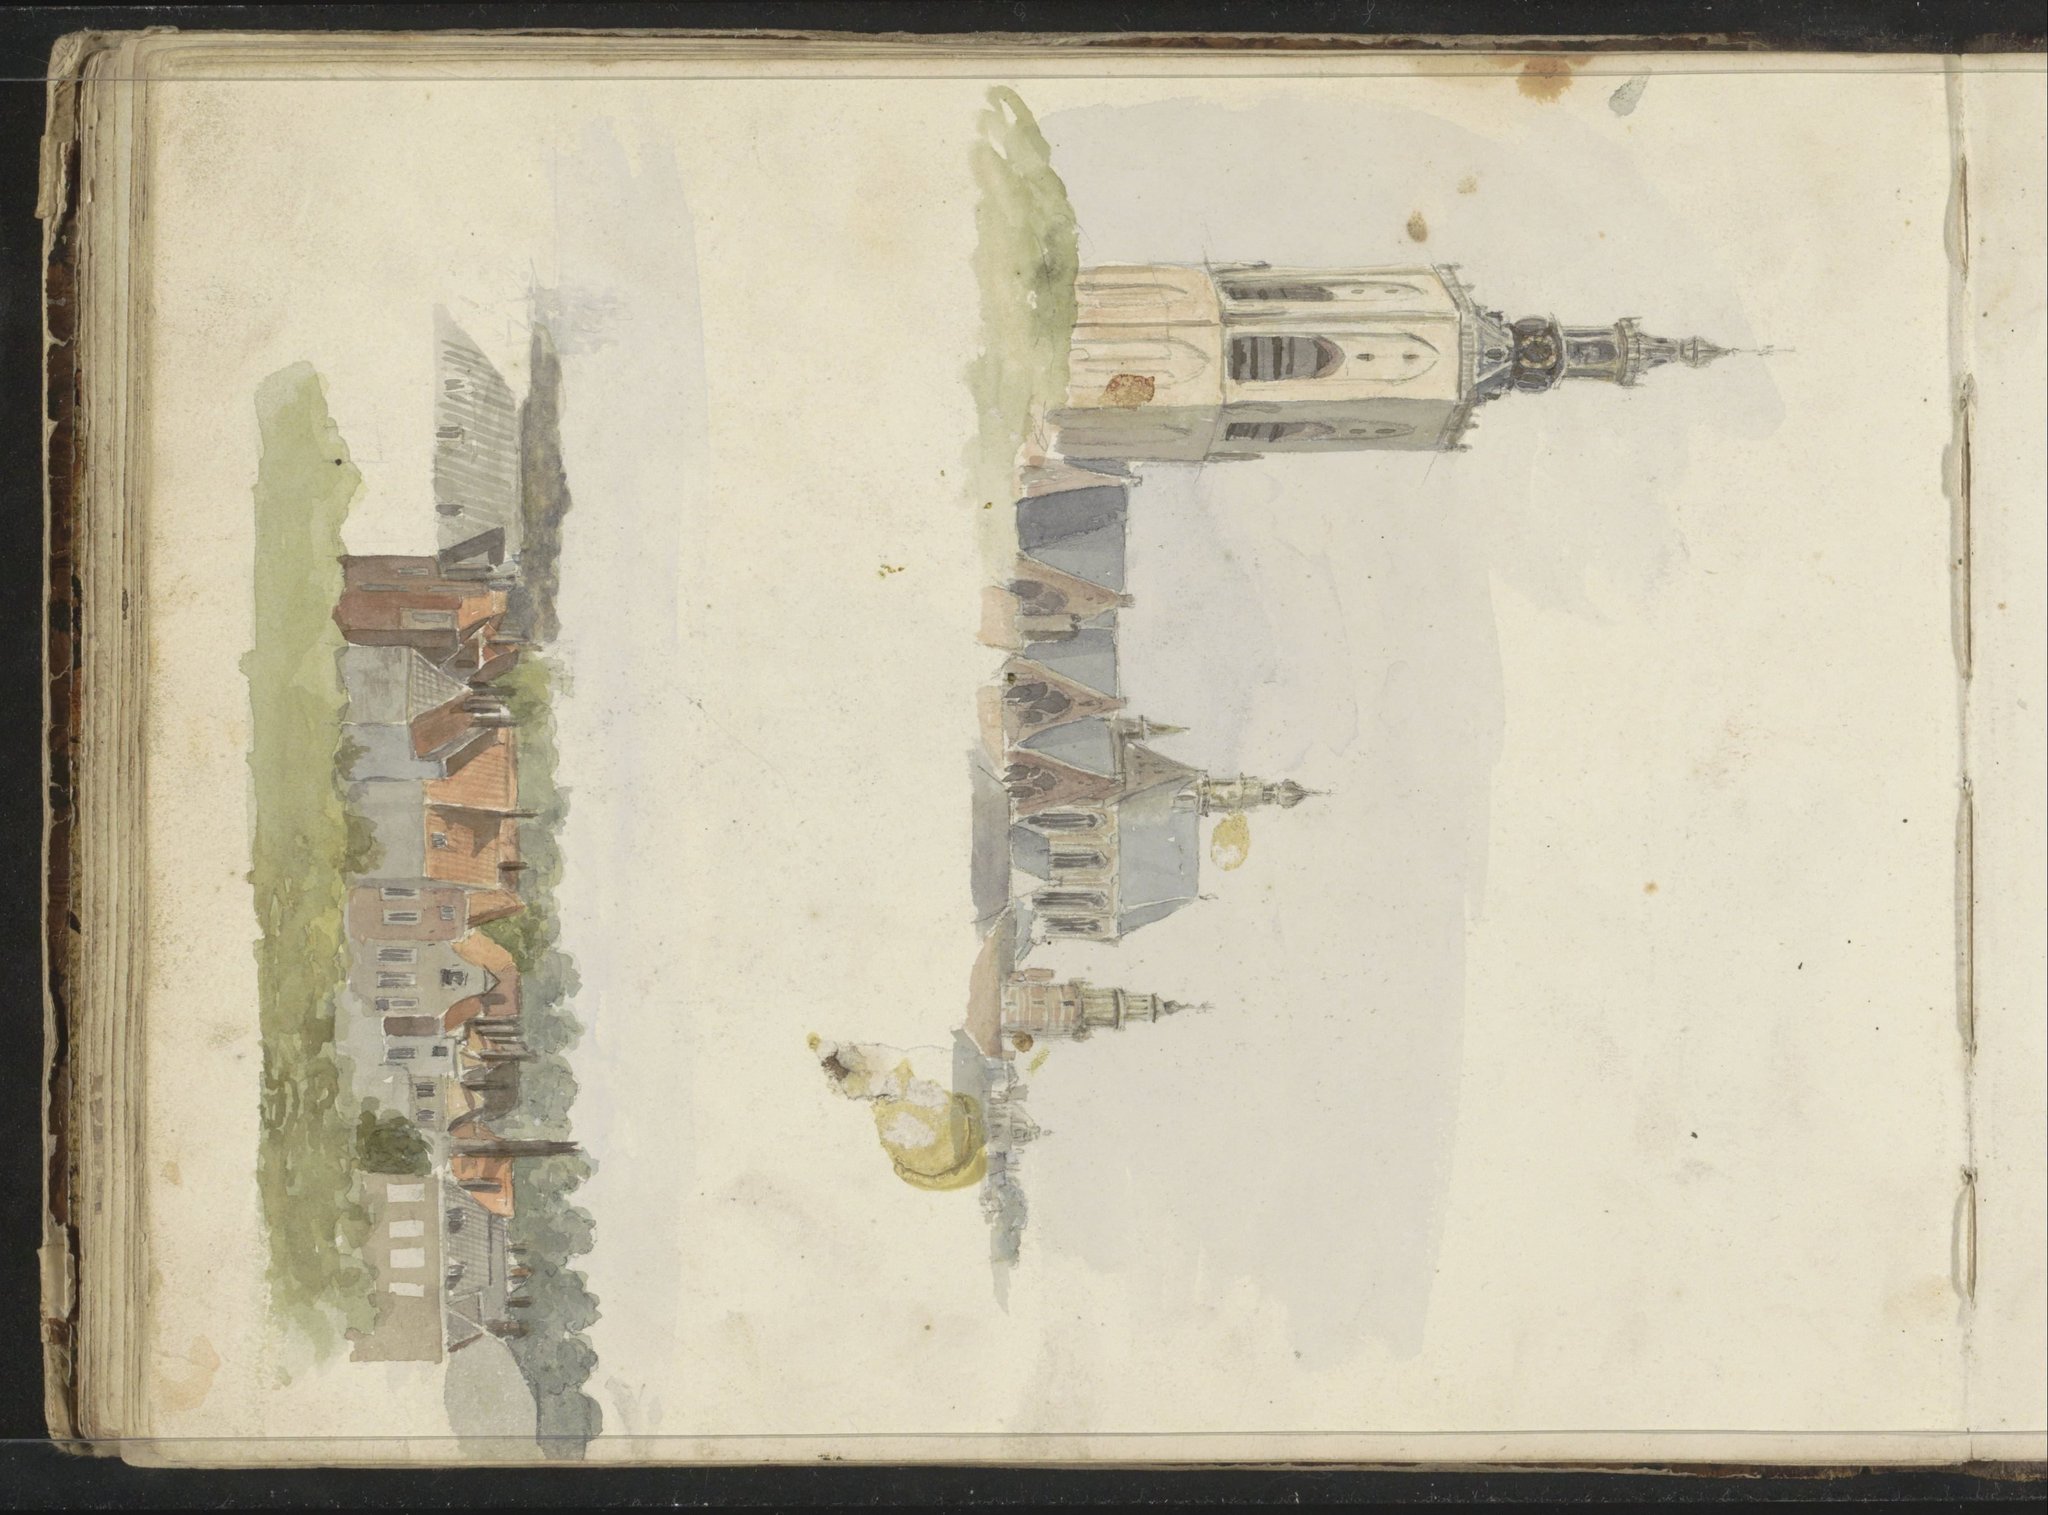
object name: sketchbook leaf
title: Gezicht op Den Haag met de Grote Kerk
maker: willem troost (ii)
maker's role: draughtsman, painter, print maker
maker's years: 1812-1893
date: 1822-1893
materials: paper, pencil, watercolor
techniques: brush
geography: the hague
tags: city-view, and landscape with man-made constructions, church (exterior)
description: Tevens een stadsgezicht. Blad 58 verso uit een schetsboek met 36 bladen.